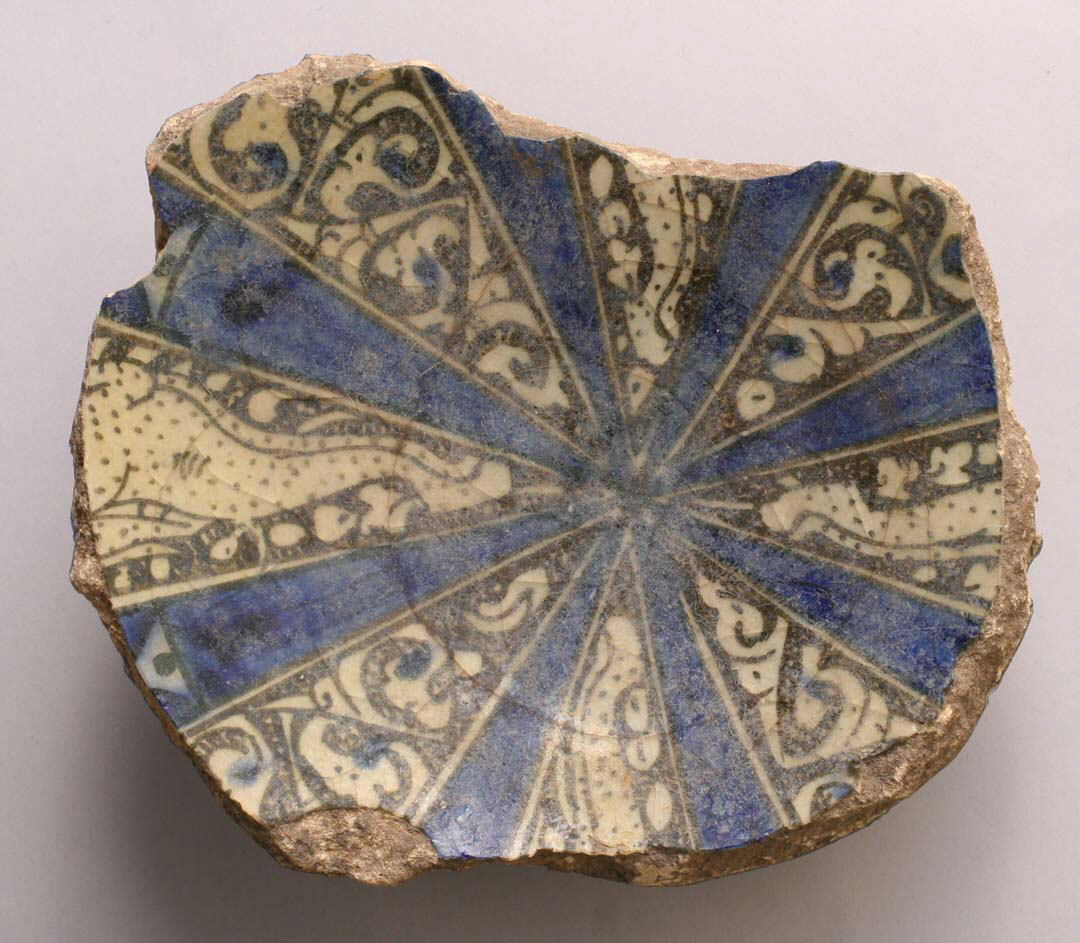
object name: fragment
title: Fragment of a Bowl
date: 1201-1400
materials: stonepaste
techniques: painting, underglaze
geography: syria